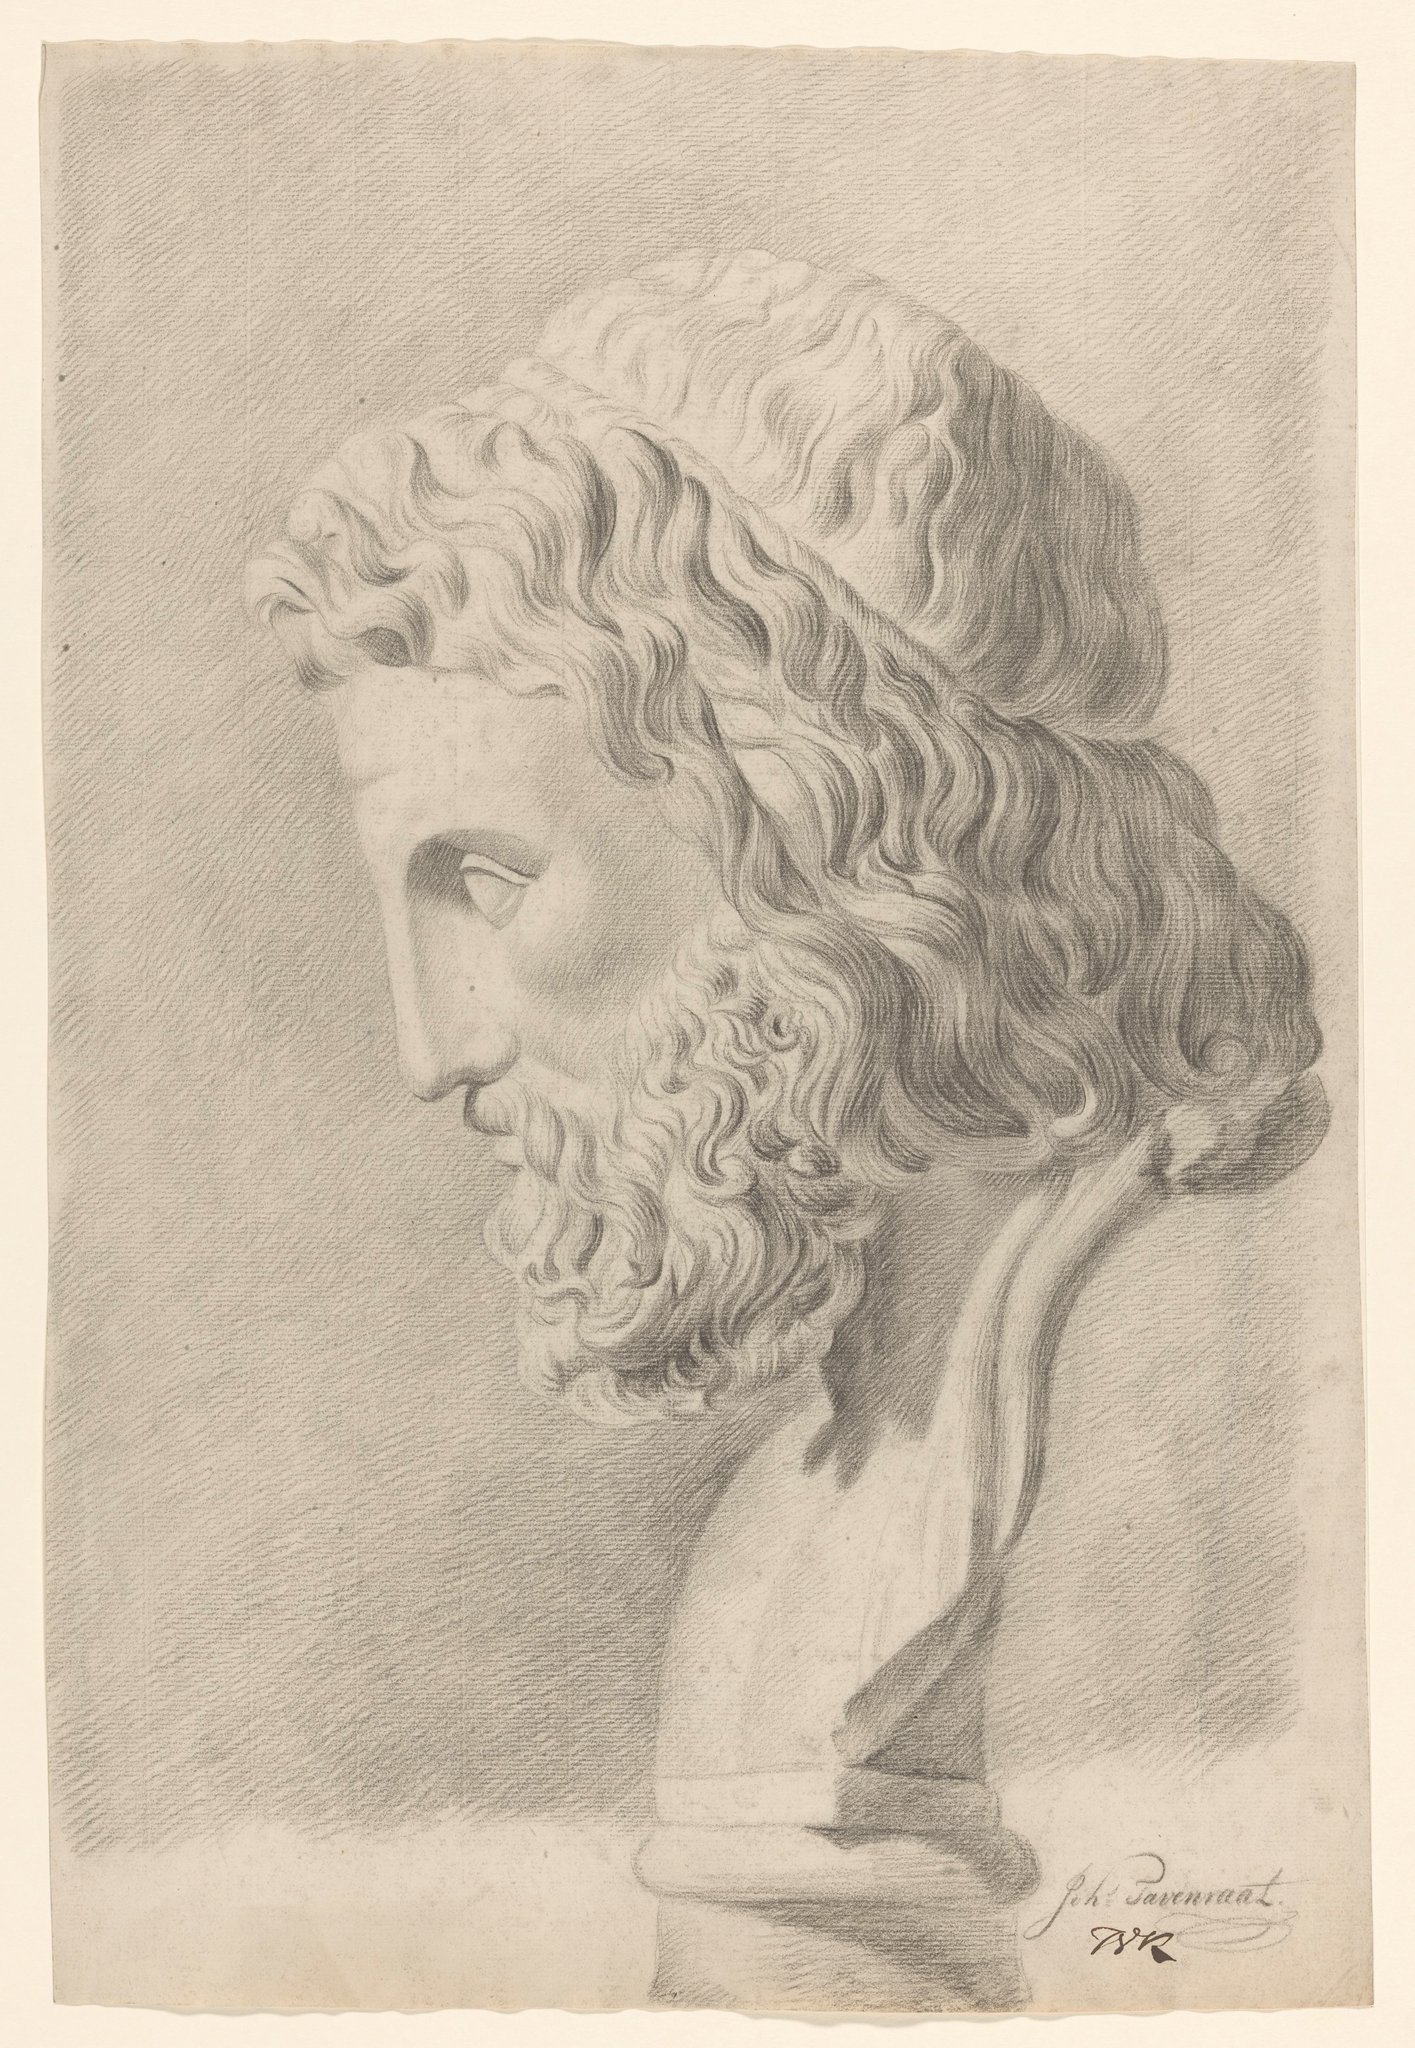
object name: drawing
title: Academiestudie naar gips van antieke buste van een man met baard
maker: johannes tavenraat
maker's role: draughtsman, painter, print maker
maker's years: 1809-1881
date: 1819-1881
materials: chalk, paper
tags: piece of sculpture, reproduction of a piece of sculpture (+ ceramics ~ arts)